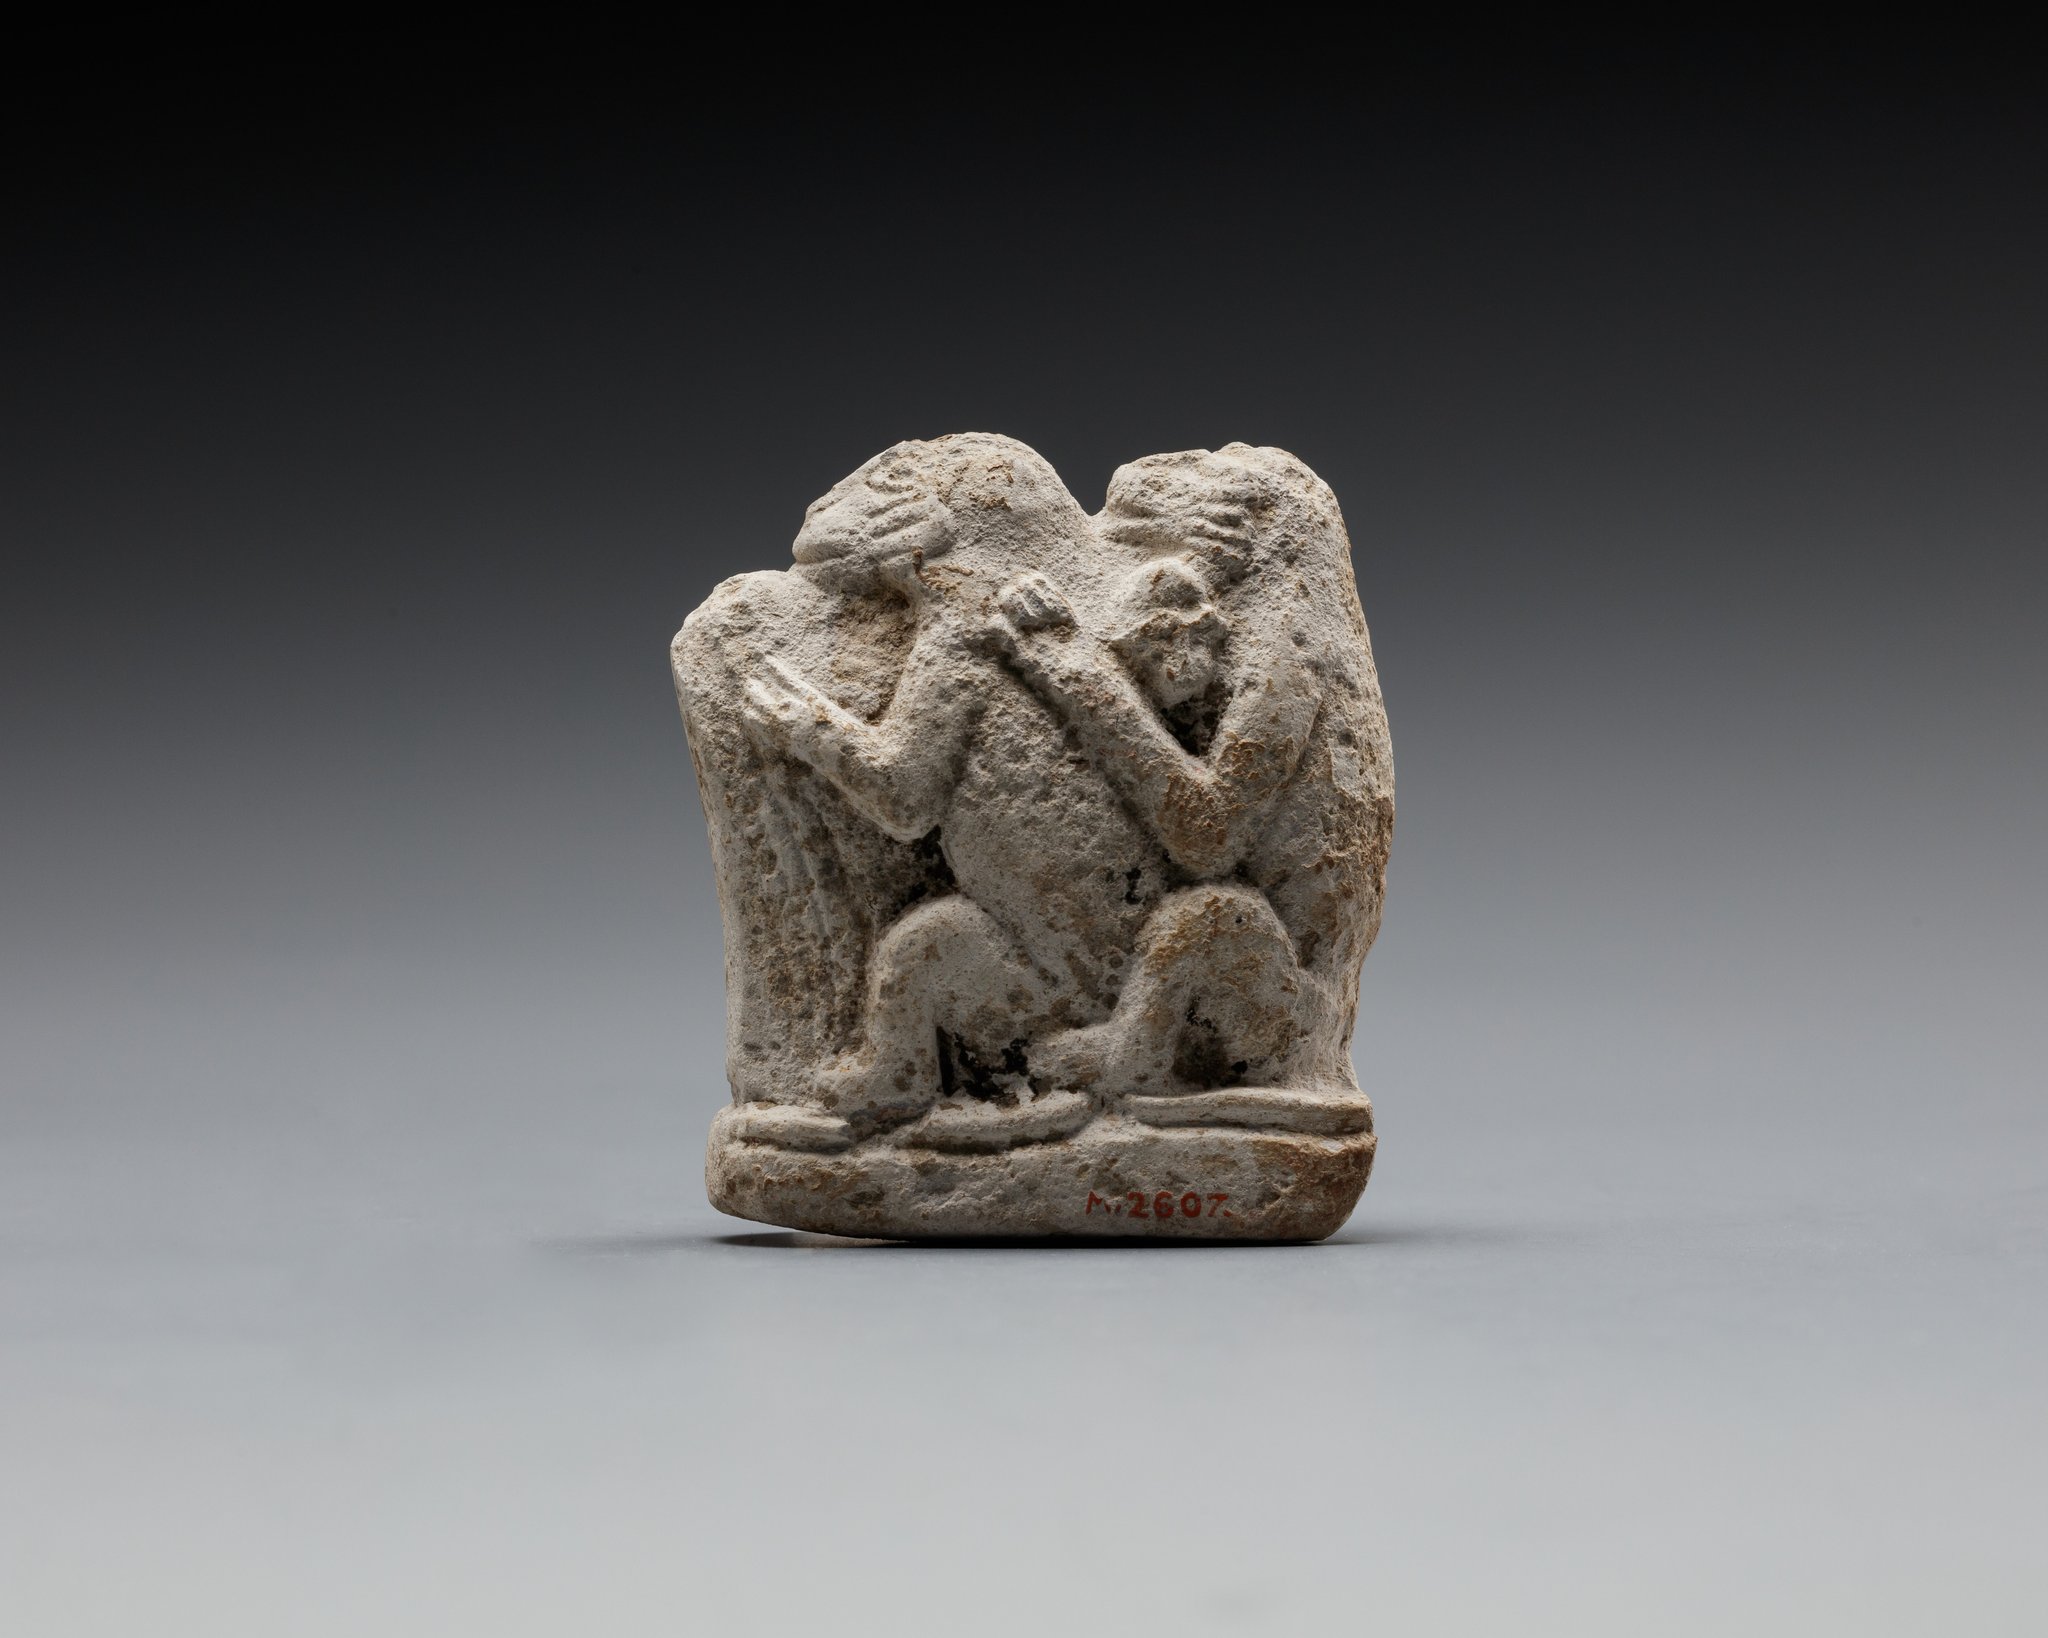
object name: figurine, monkey couple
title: Monkey couple, the first playing a harp?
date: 1350-1070 BCE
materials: limestone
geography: egypt